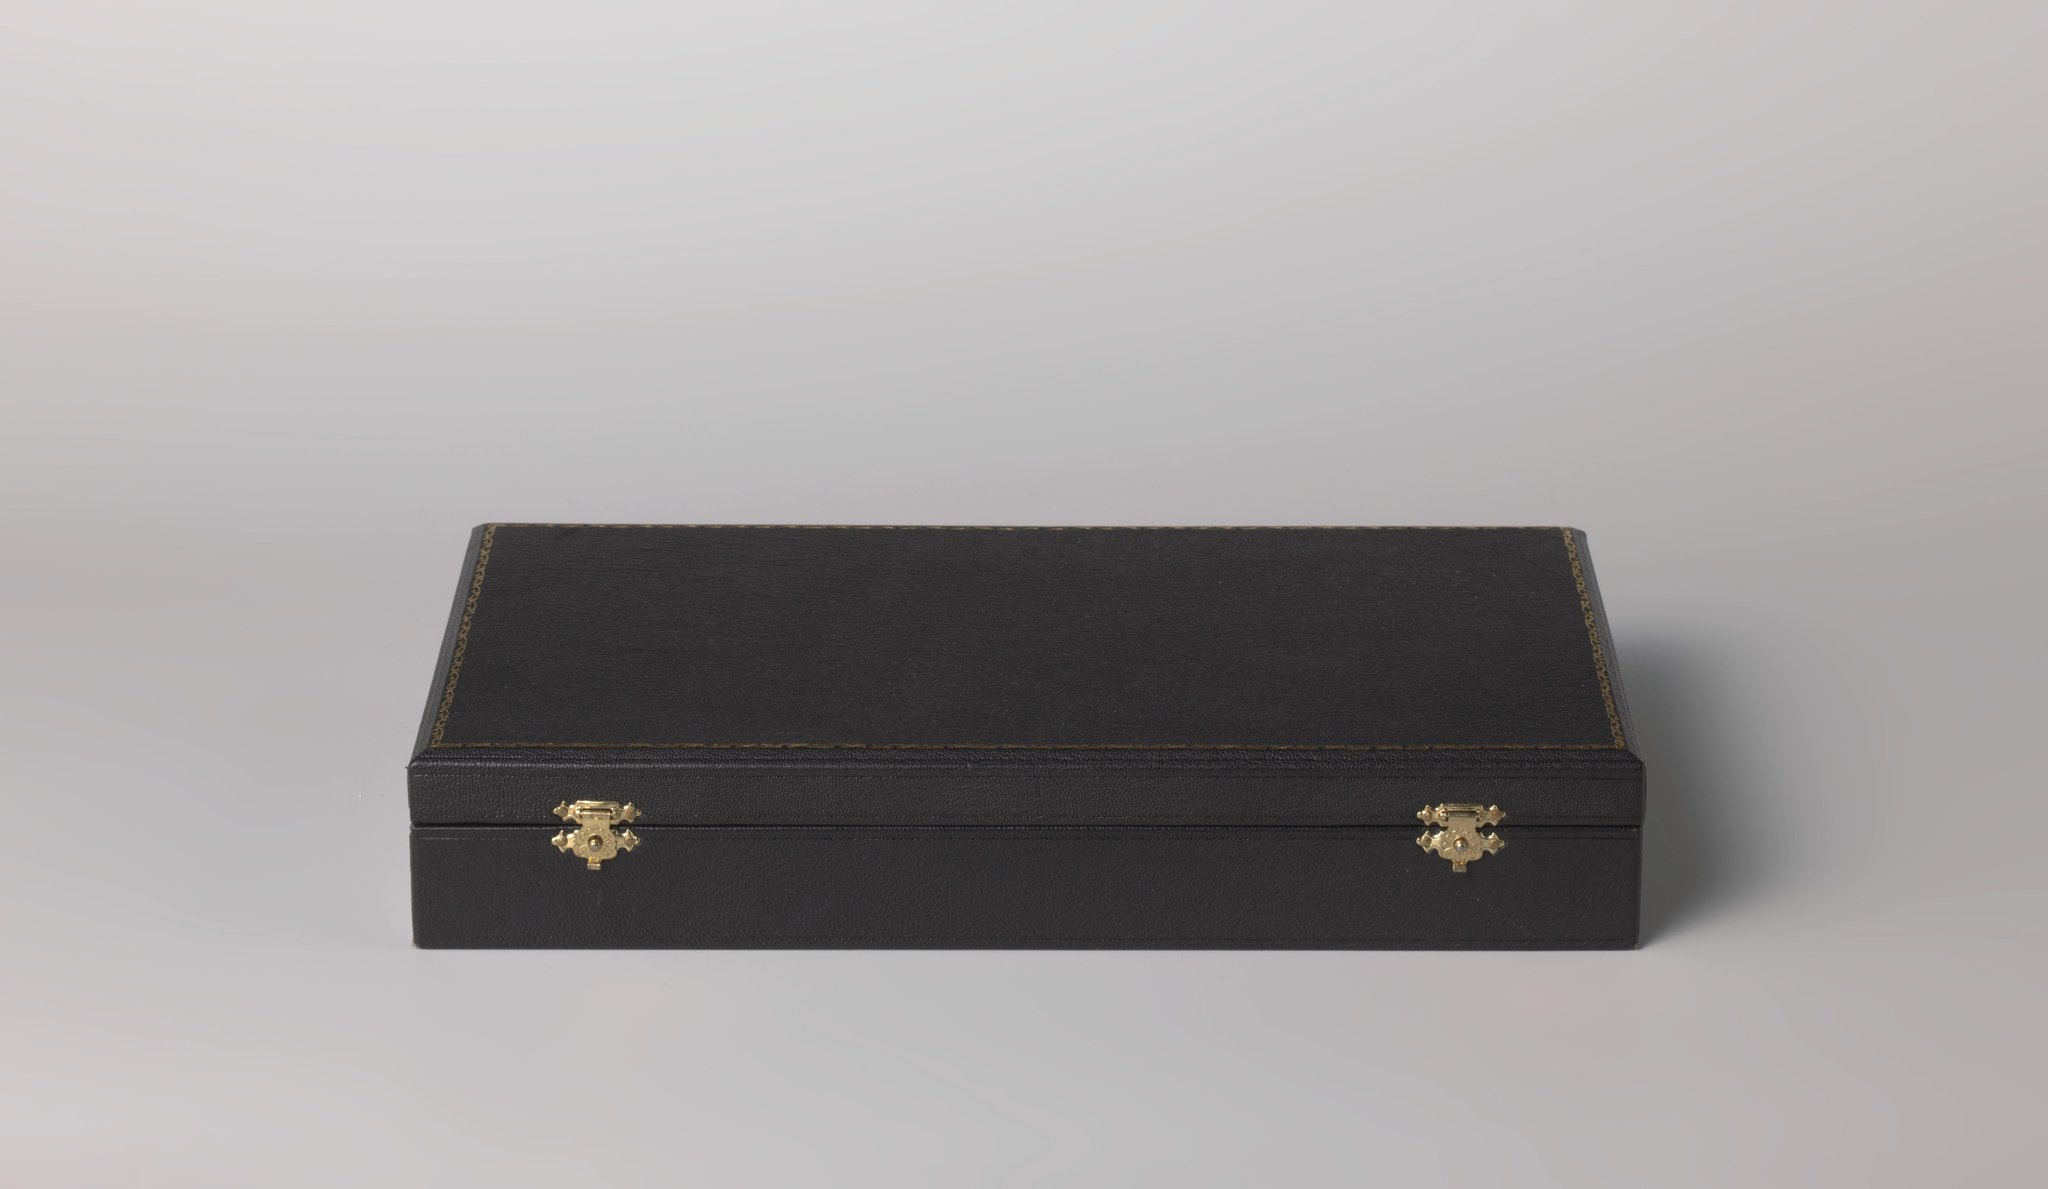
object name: box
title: Doos voor vork en lepel van zwart leer en met gouden rand op deksel. Twee slotjes.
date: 1900-2000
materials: leather, wood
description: Lepel met waaiervormige steel, op de voor- en achterzijde gedecoreerd met bamboeranken in laag reliëf en aan de voorzijde, tussen deze ranken, met een ovaal medaillon met een W. Gemerkt KHC.